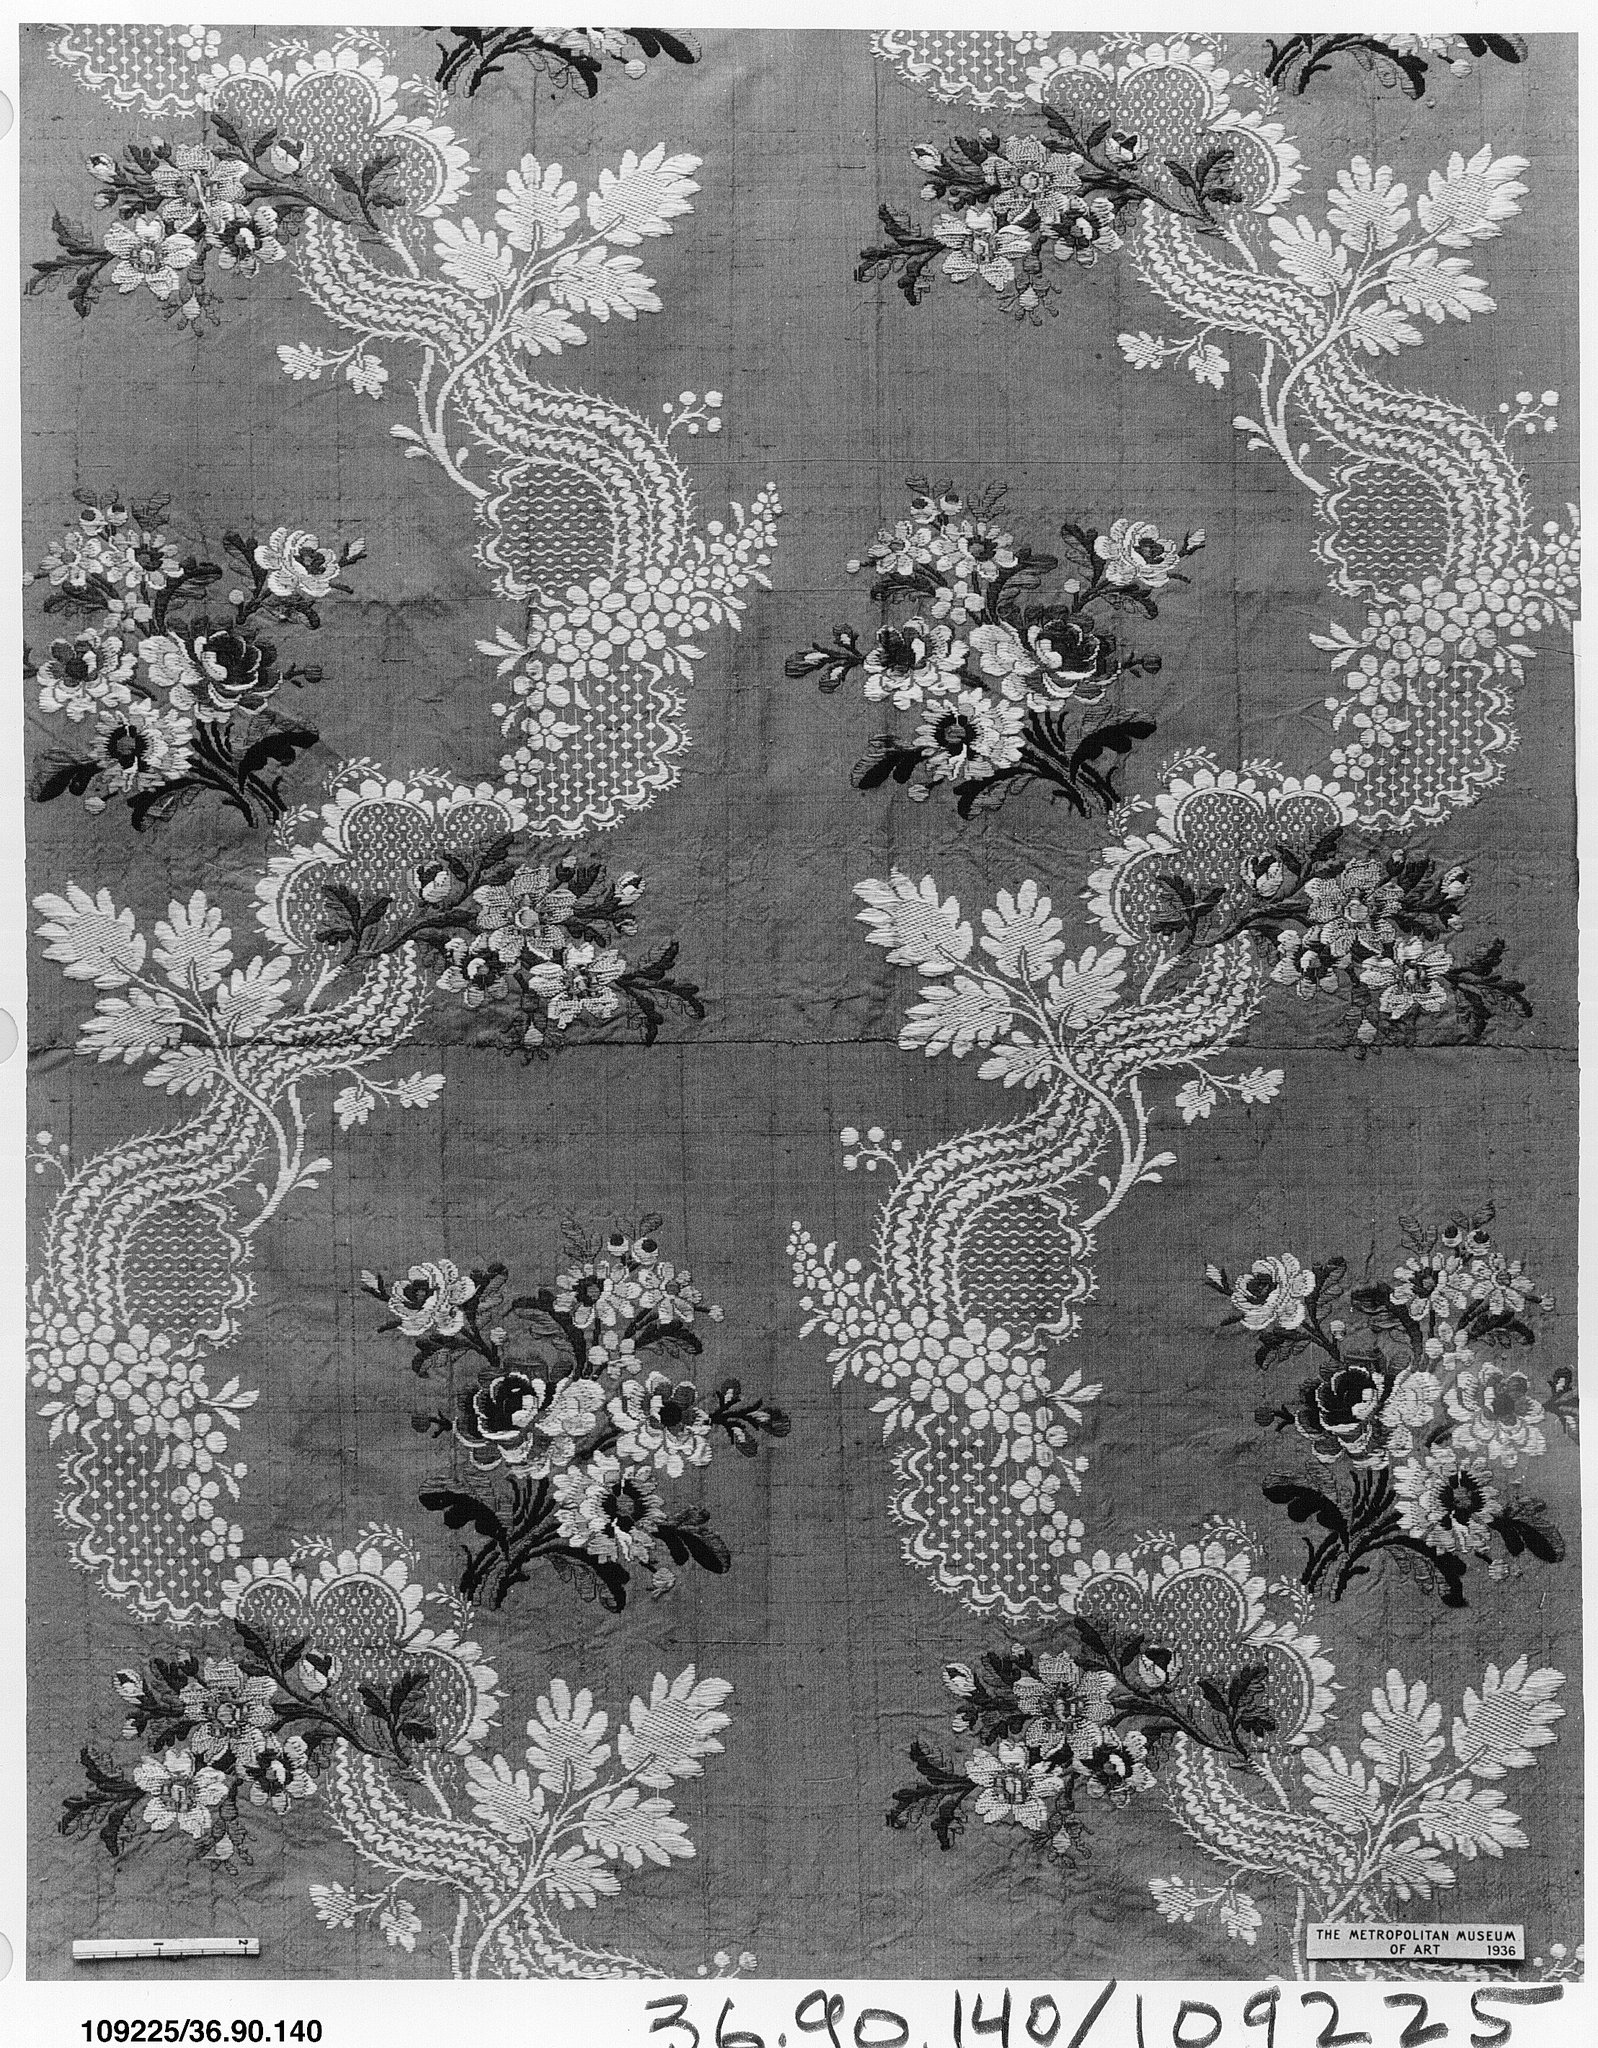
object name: piece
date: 1750-1760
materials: silk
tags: flowers,leaves